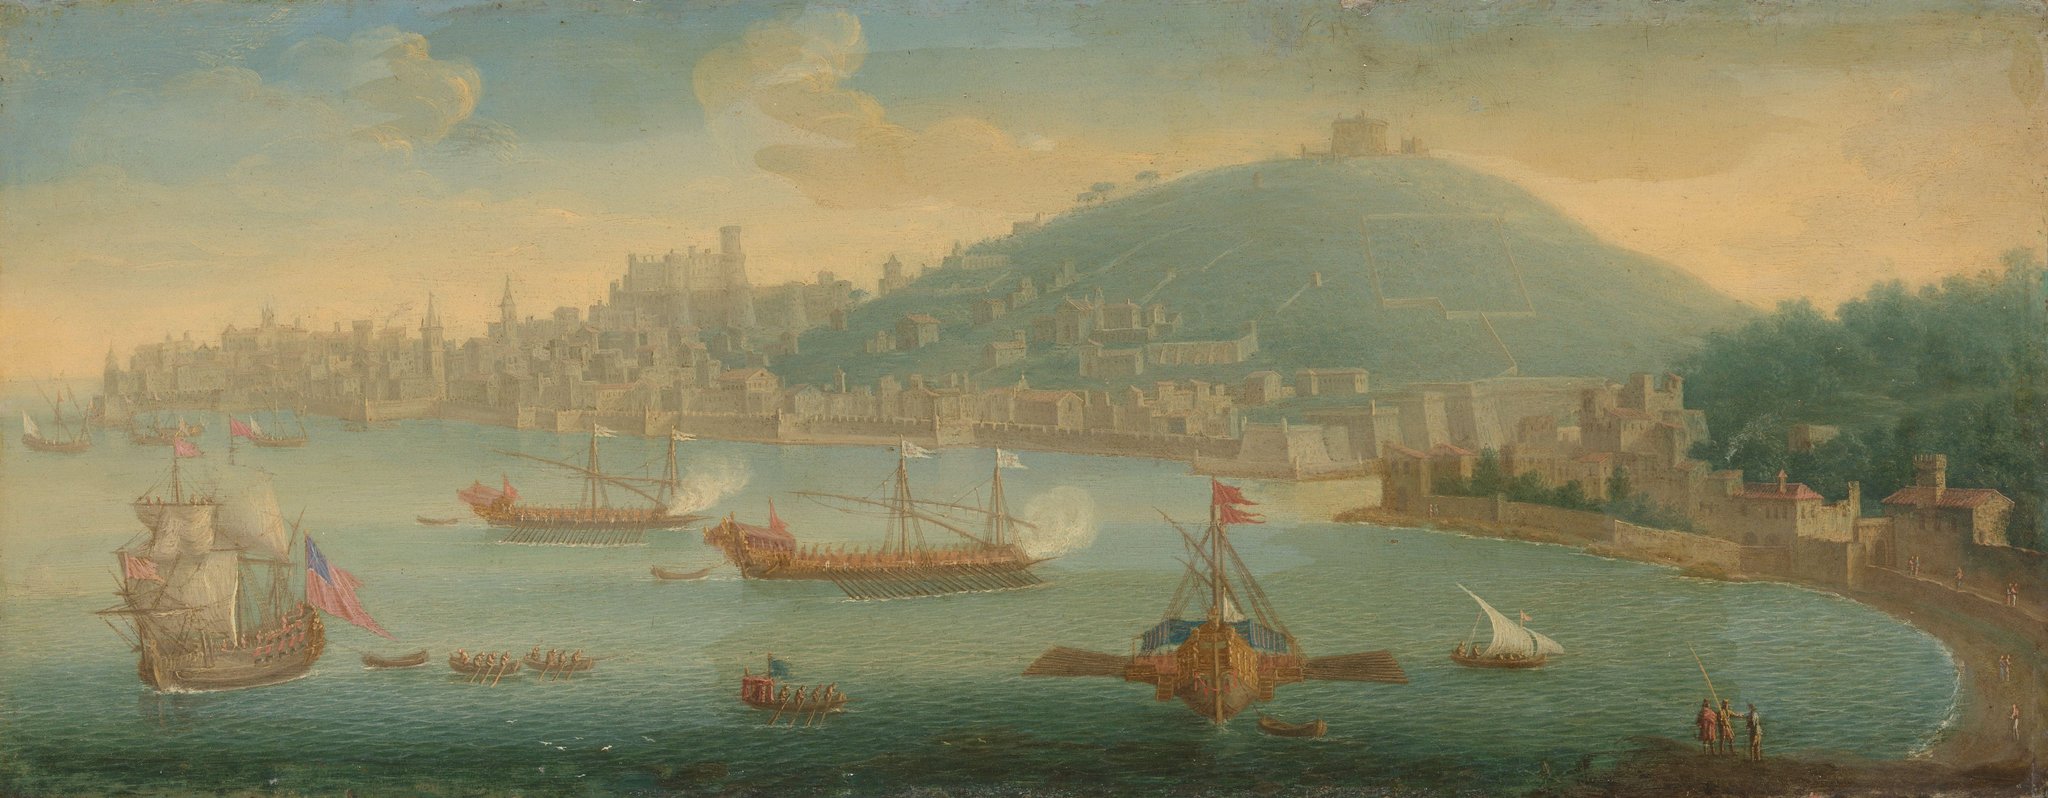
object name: painting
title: Gezicht op Napels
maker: caspar van wittel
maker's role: draughtsman, painter, print maker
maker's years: 1652-1736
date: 1675-1750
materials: copper, oil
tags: harbour, prospect of city, town panorama, silhouette of city, naples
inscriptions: inscription: ‘Vanvitelli’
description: Gezicht op de stad Napels. In de baai verschillende galeien en andere schepen. Pendant van SK-A-2660.